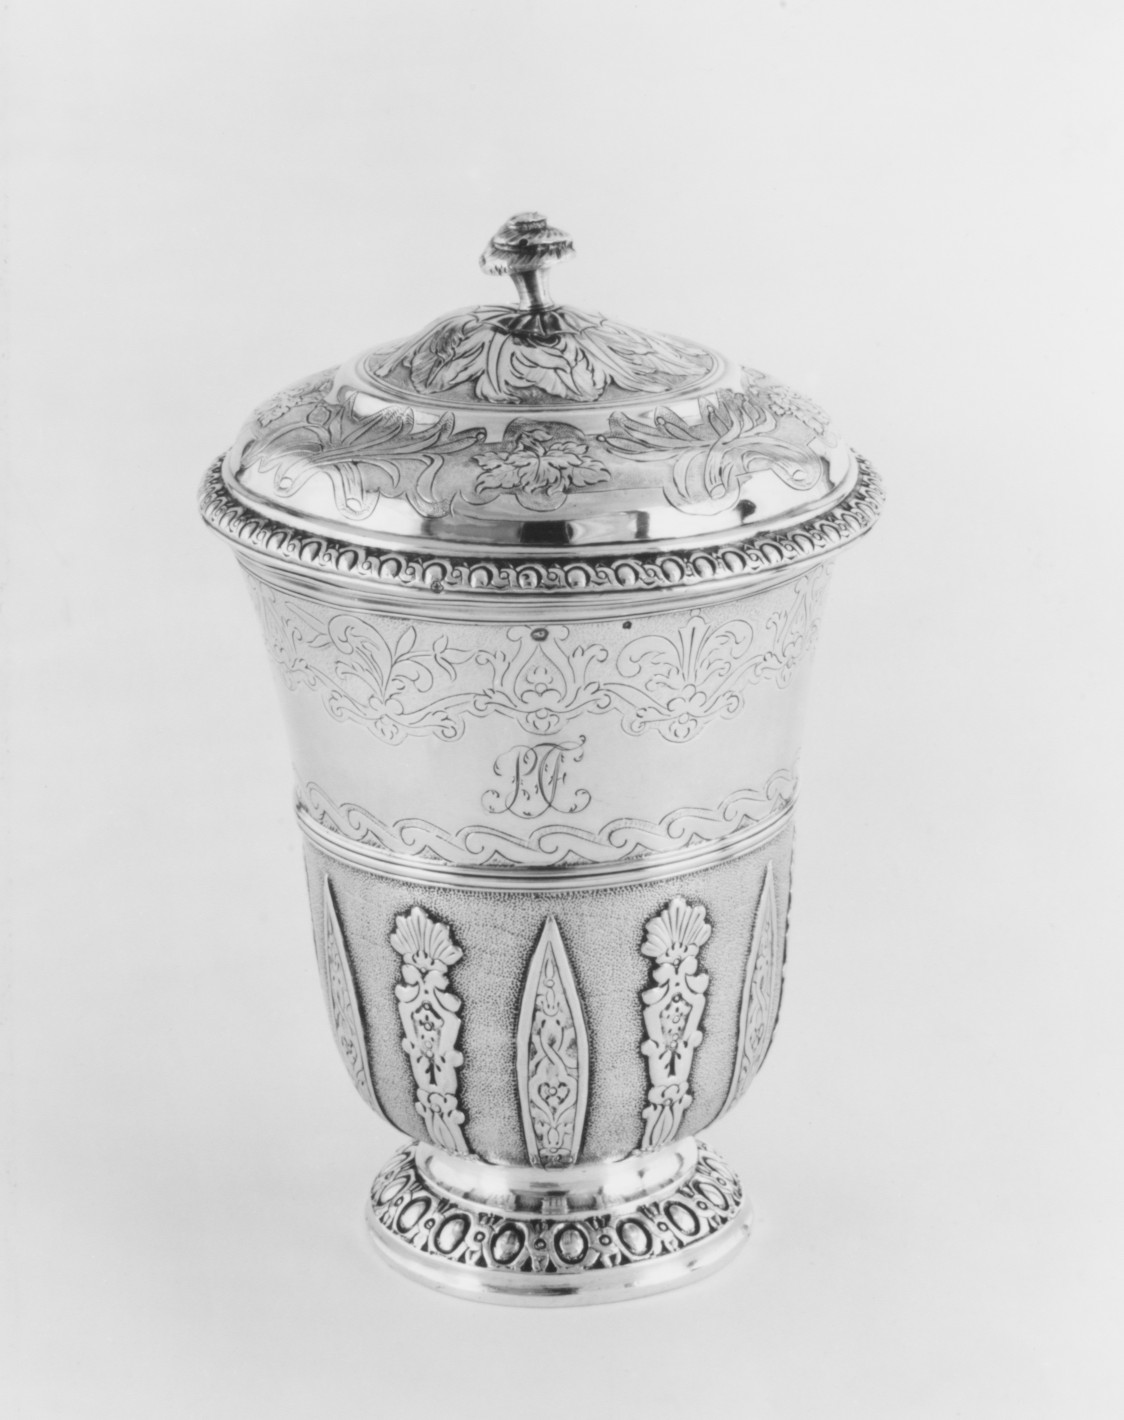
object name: beaker with cover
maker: claude charvet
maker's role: maker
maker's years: 1651-1751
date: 1746-1757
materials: silver